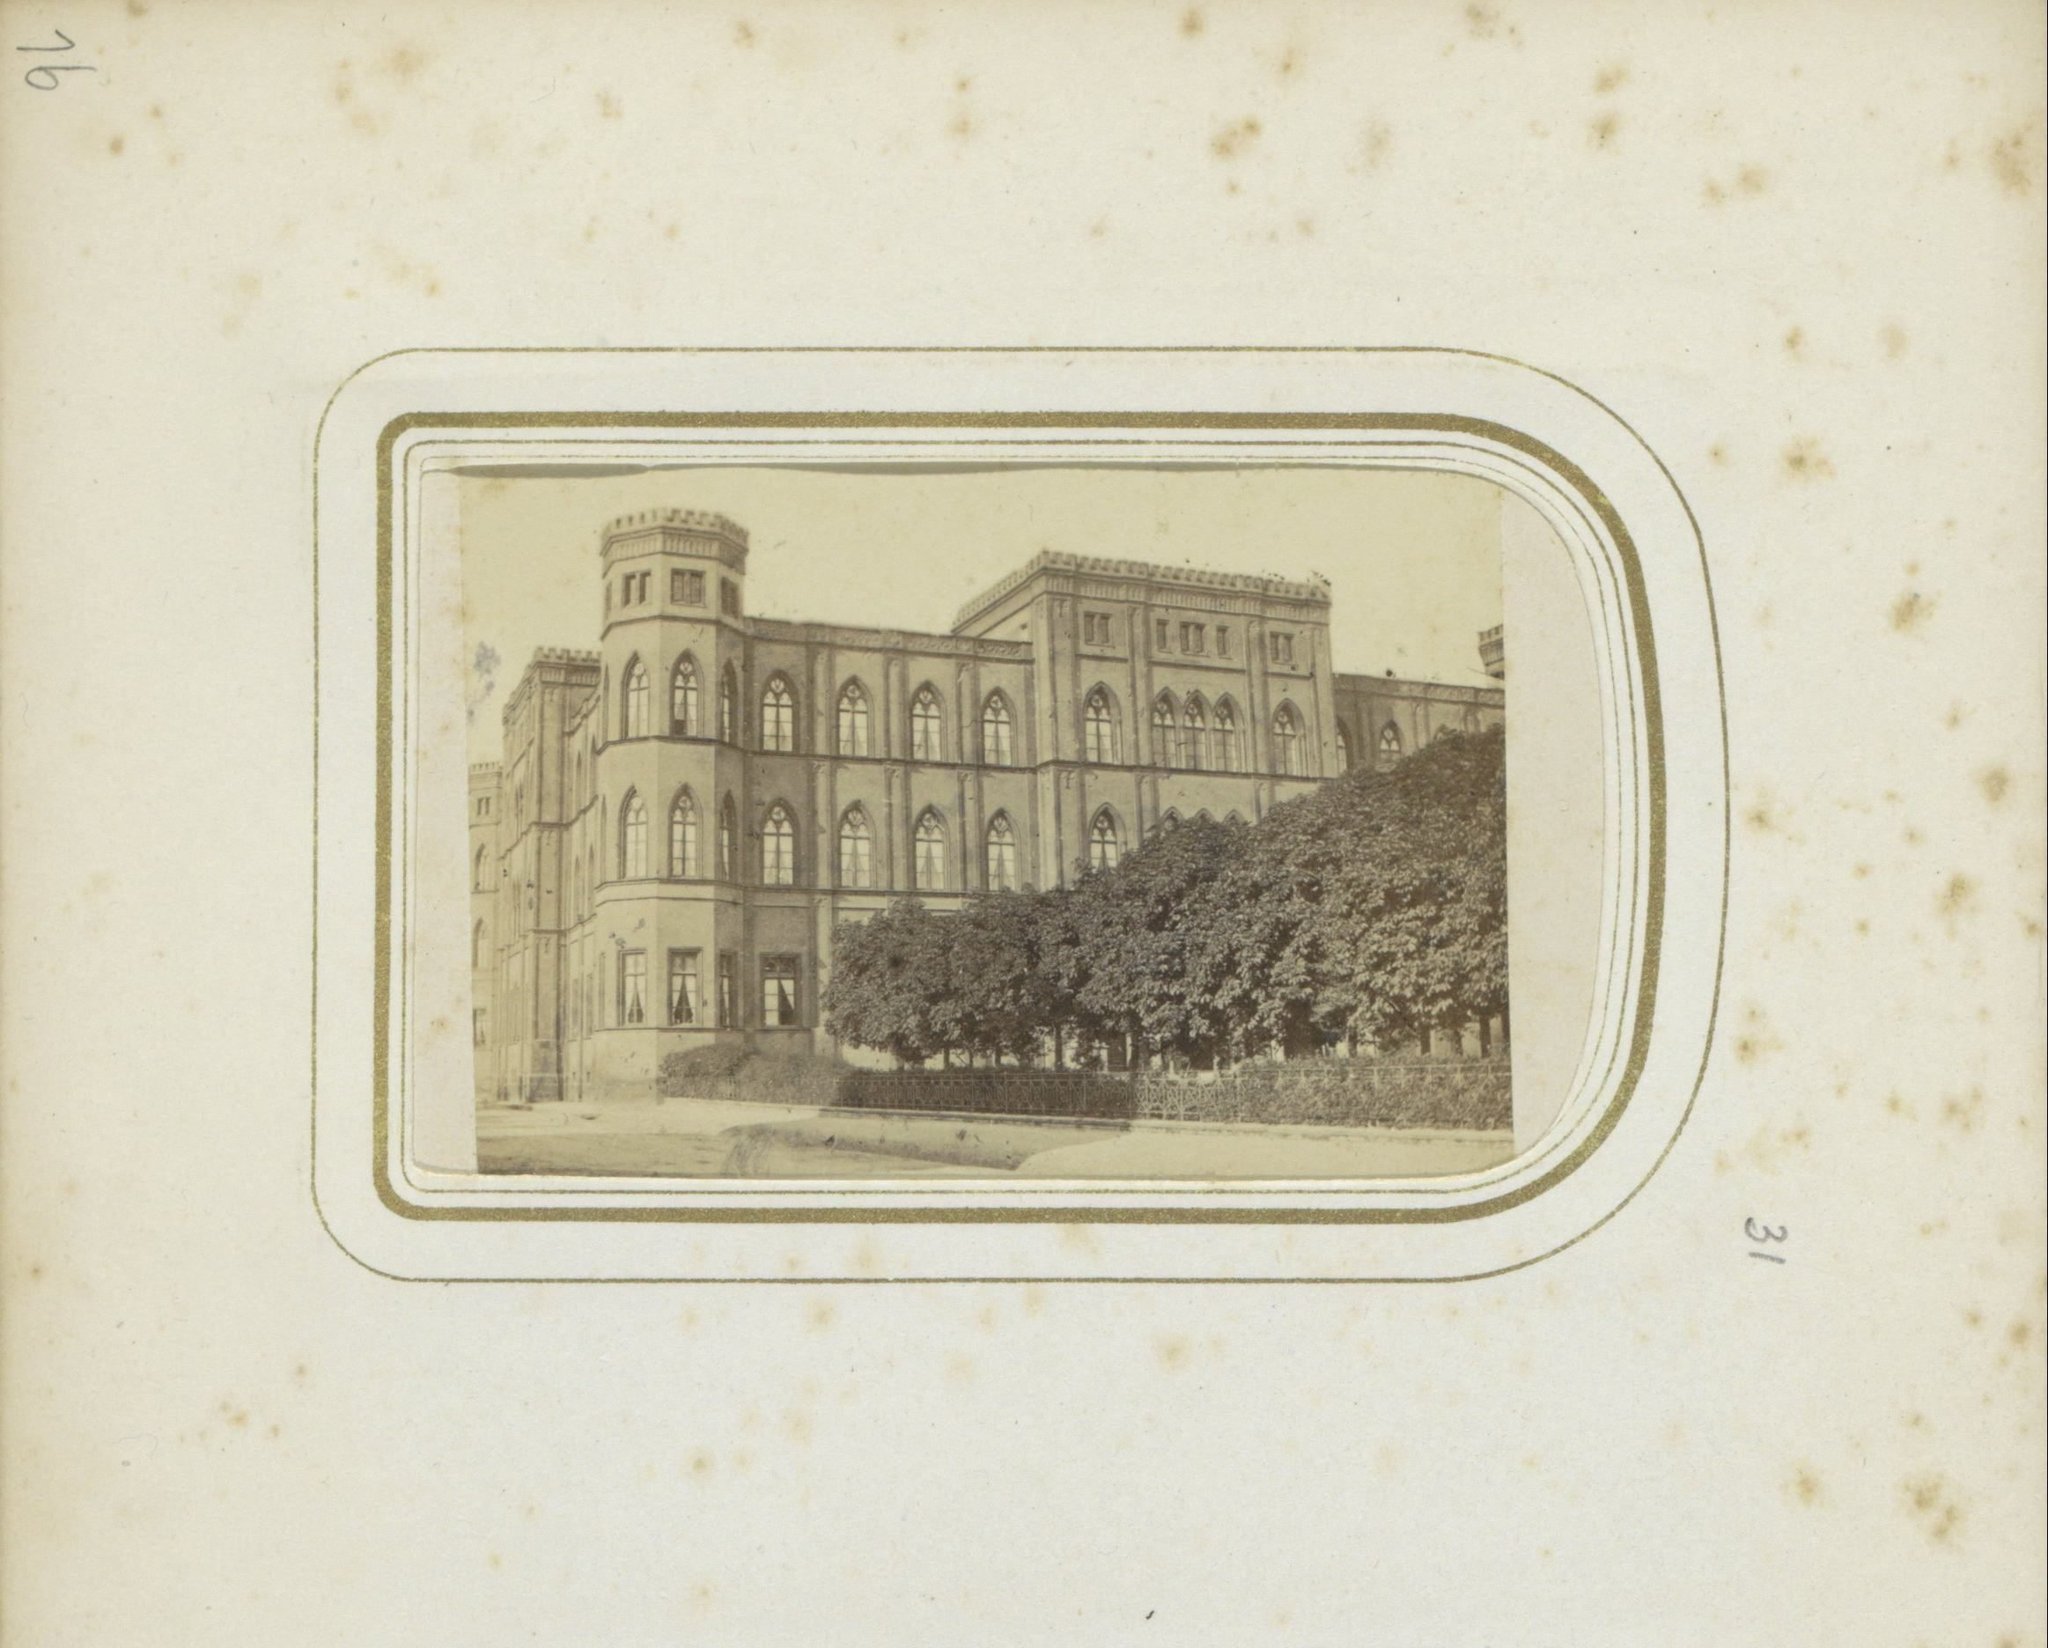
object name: photograph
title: Exterieur van het Wittelsbacher Paleis in München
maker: Anonymous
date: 1865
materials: paper, photographic support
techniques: albumen print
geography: munich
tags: trees, tower, clock tower ~ monumental adornment, palace, travelling; tourism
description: Onderdeel van Fotoalbum van een reis door Zwitserland, Oostenrijk en Duitsland door de Nederlandse familie Derkinderen.